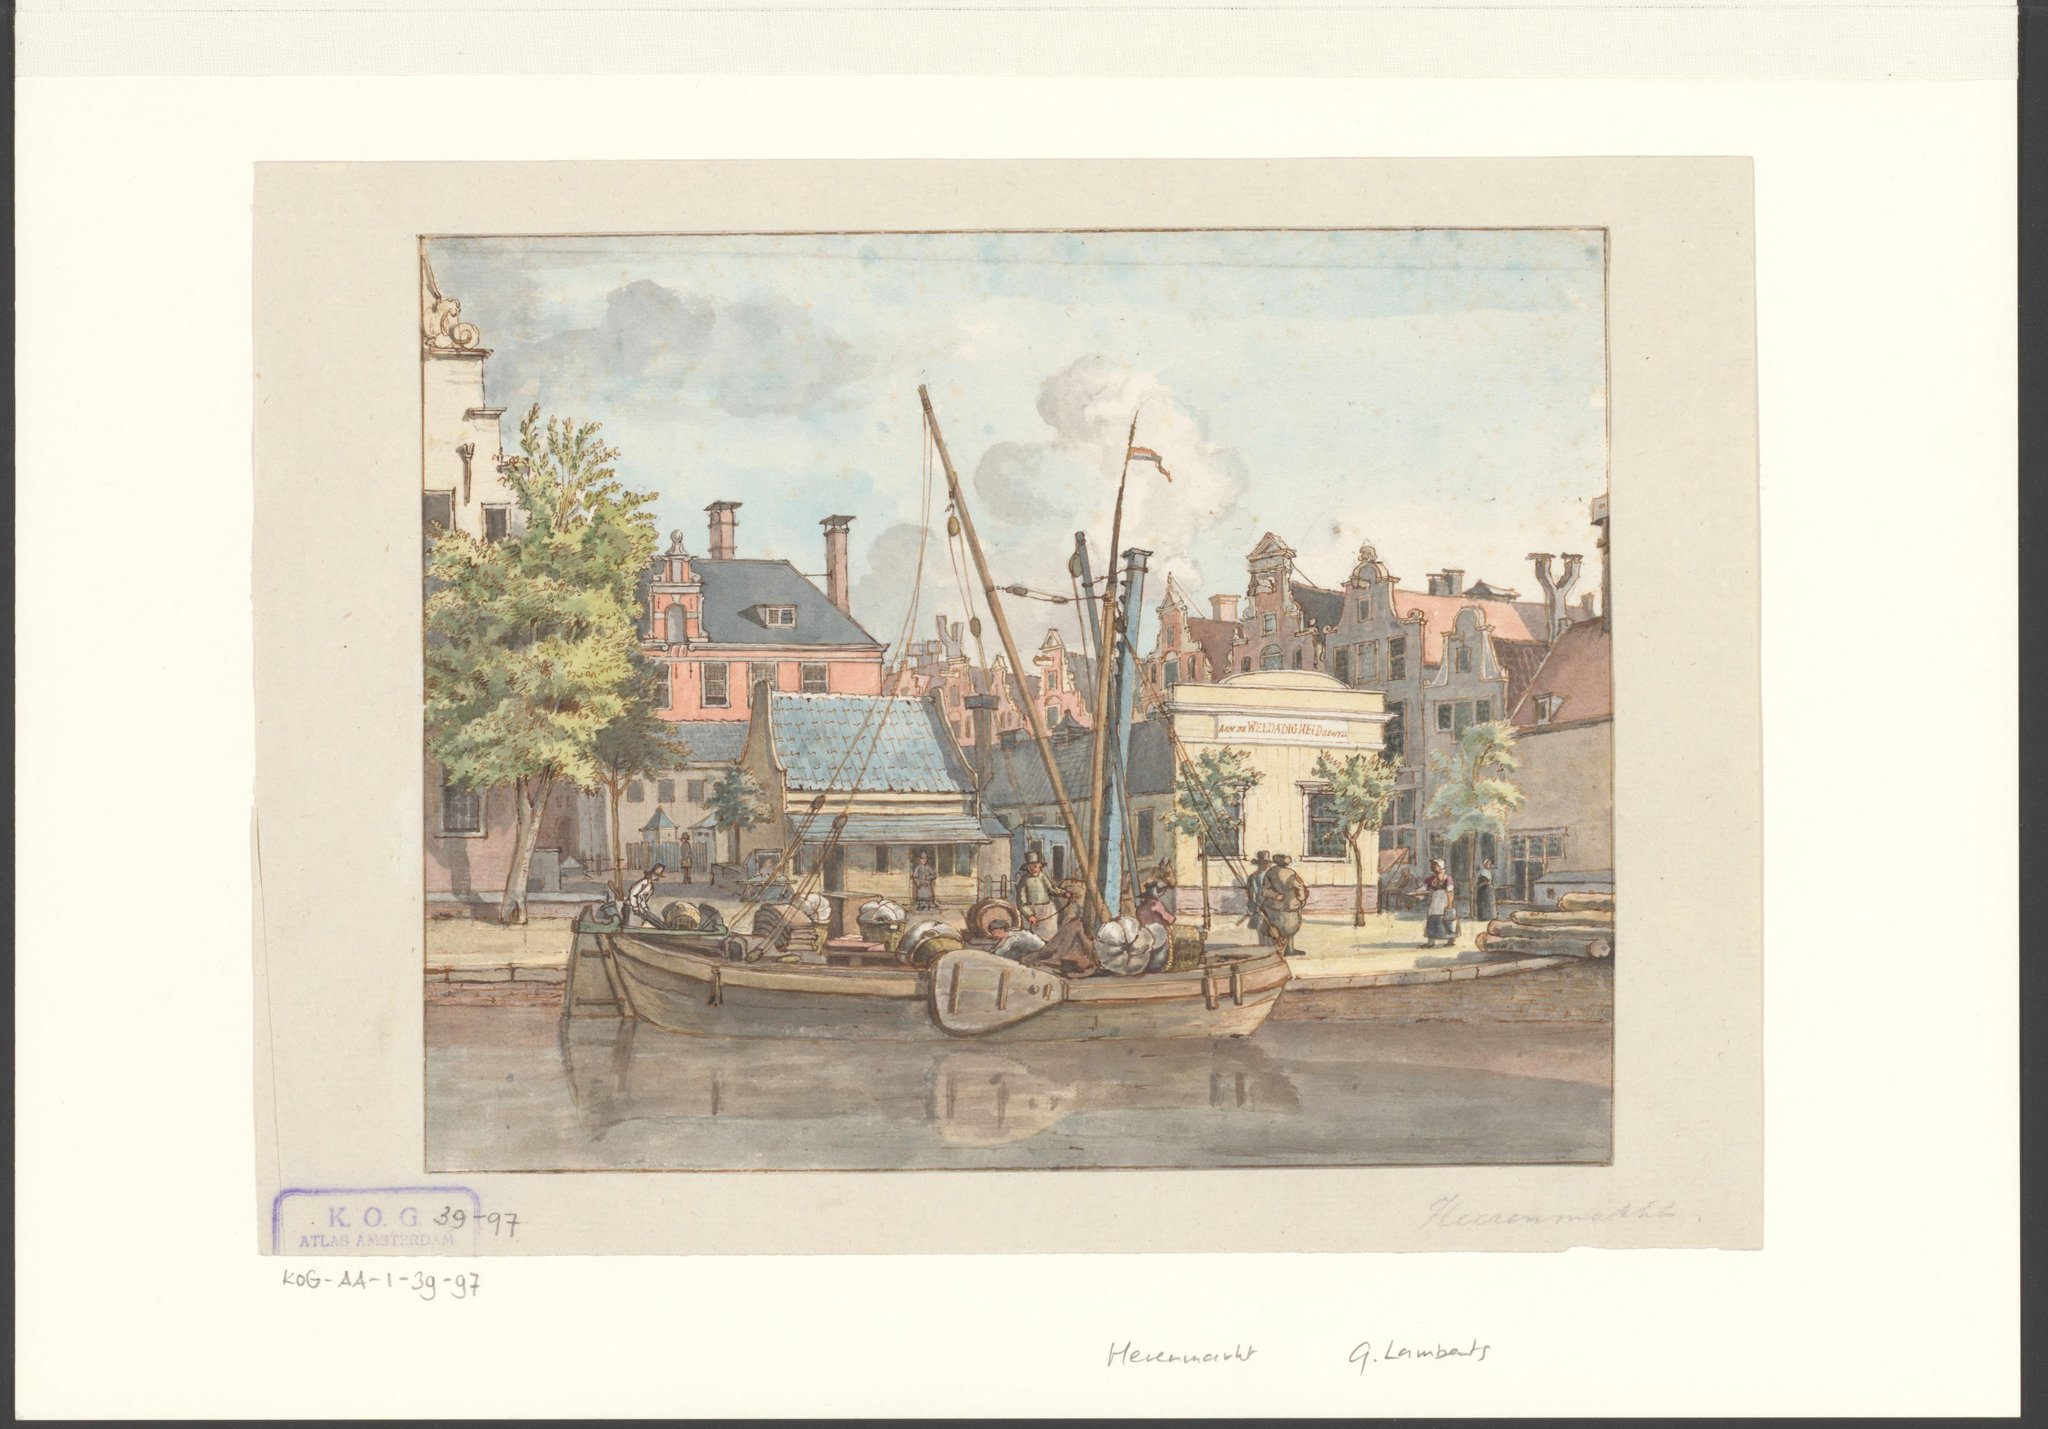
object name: drawing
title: Gezicht op de Soeploods op de Herenmarkt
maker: gerrit lamberts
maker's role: bookseller, draughtsman, print maker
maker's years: 1776-1850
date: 1816-1850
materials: ink, paper, pencil, watercolor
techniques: brush, pen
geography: amsterdam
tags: city-view in general; 'veduta', canal, shed, street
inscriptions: collector's mark: ‘39-97’ Lugt 1641b, inscription: ‘Wy wandelen de (...) Logement van agteren.’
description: Onderwerpsrubriek binnen de Atlas Amsterdam: Maatschappij van liefdadigheid - Soeploods op Heerengracht.